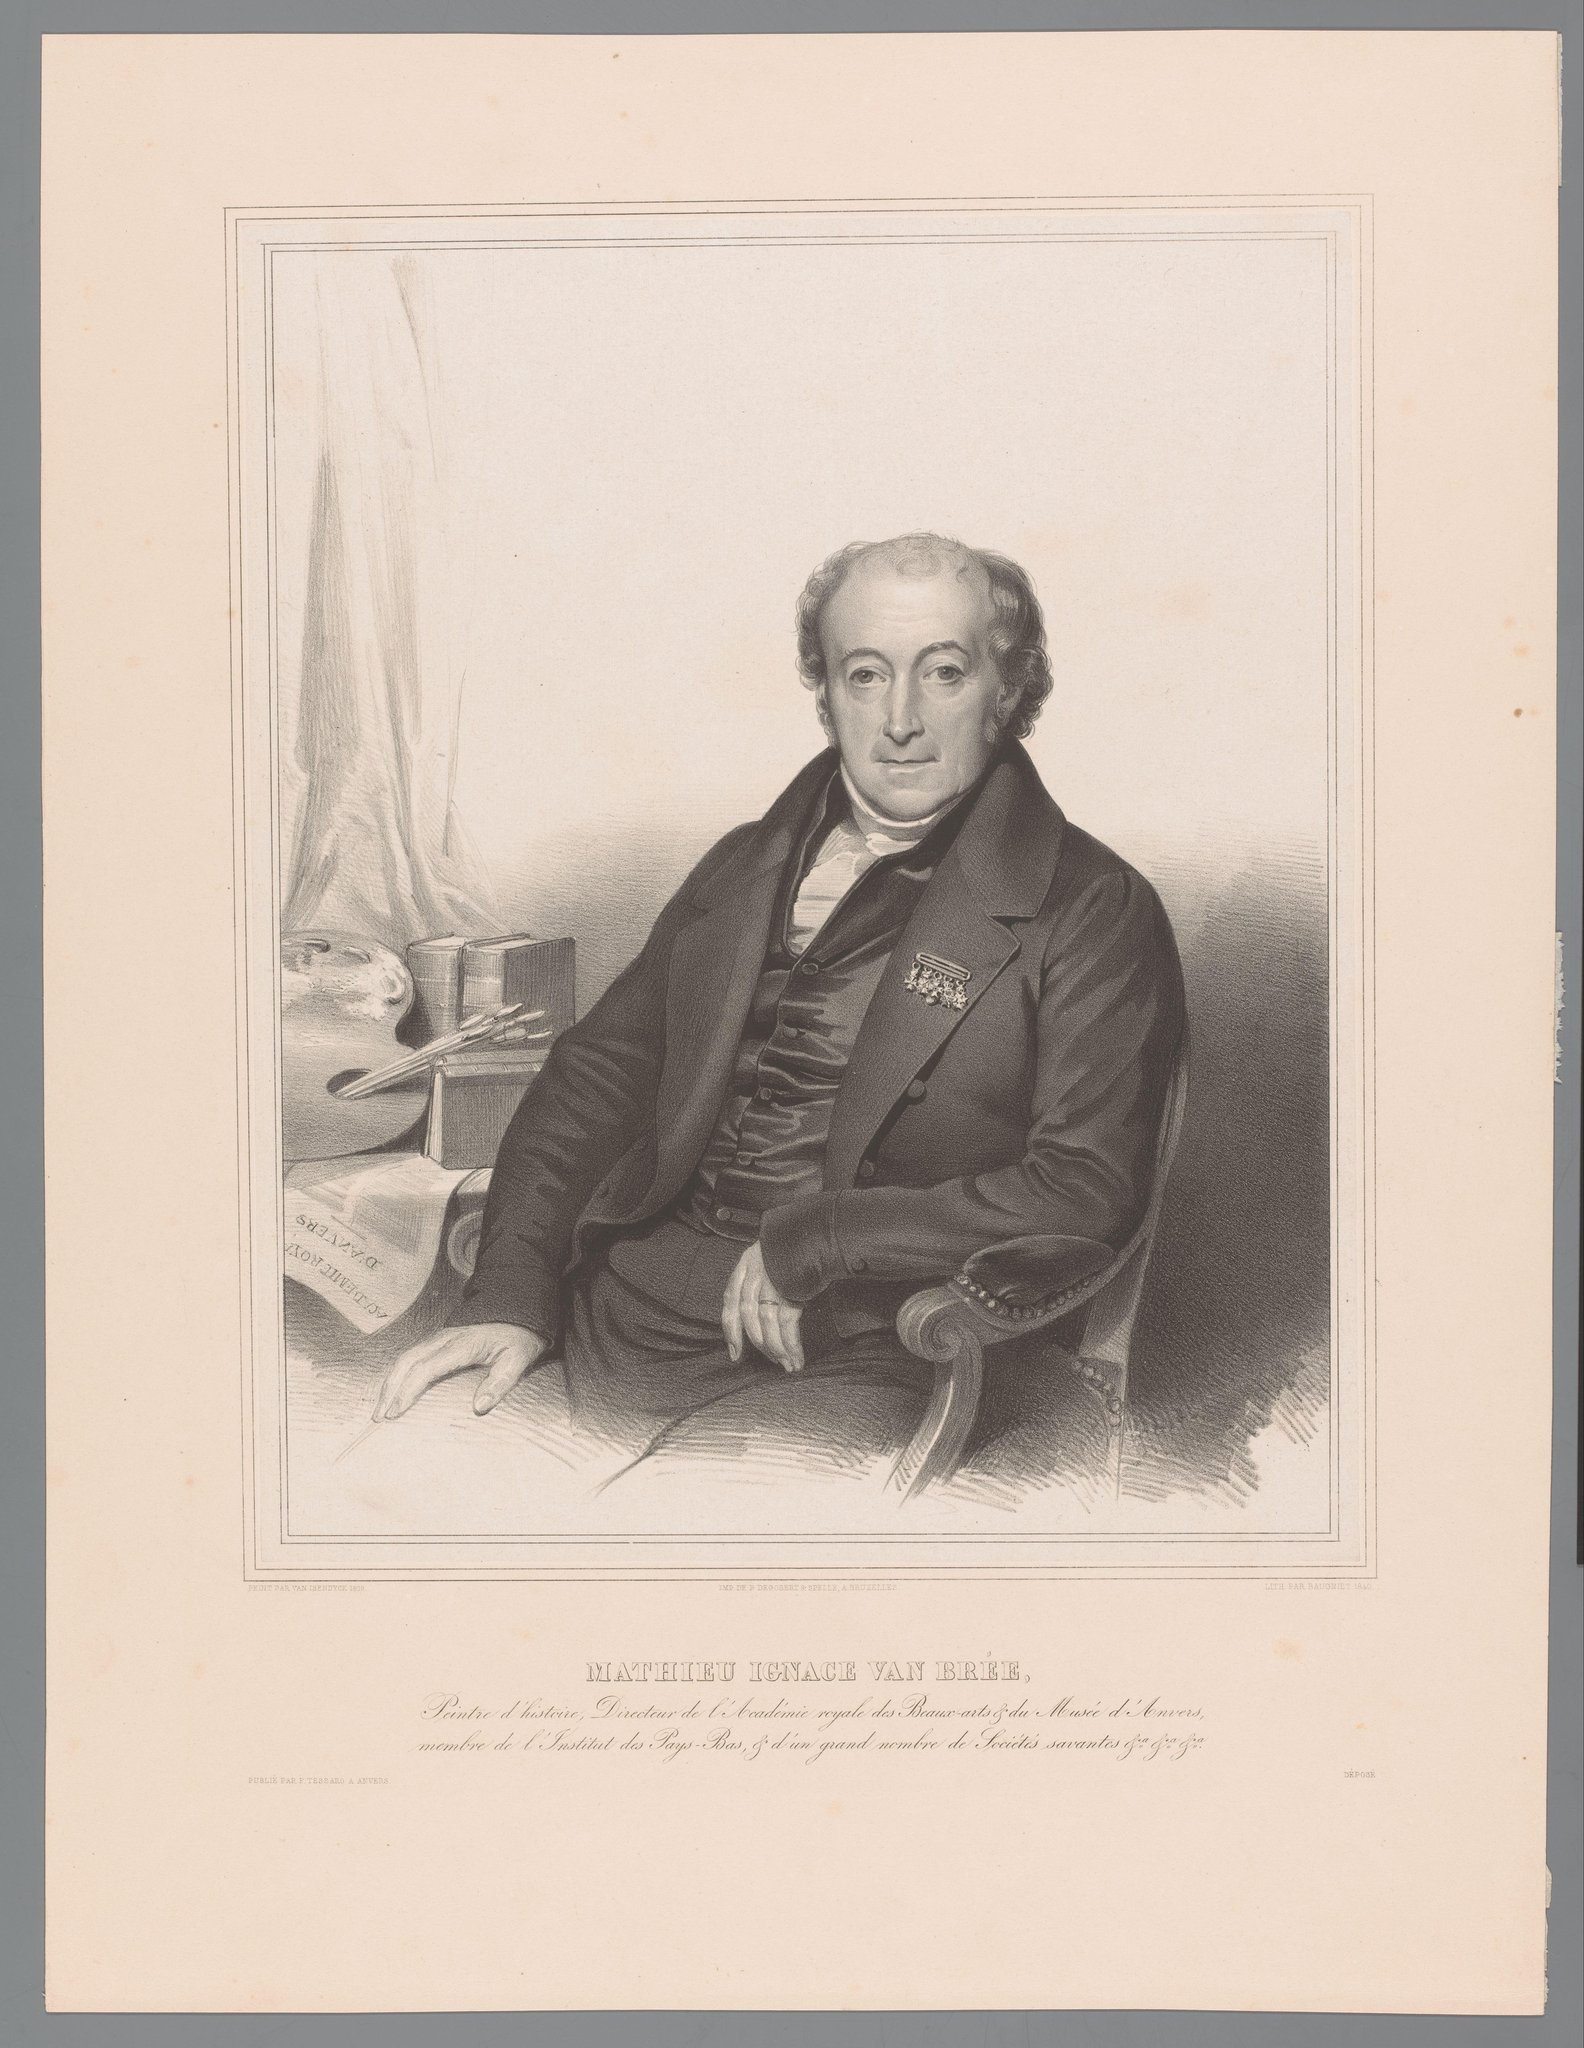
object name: print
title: Portret van Mattheus Ignatius van Bree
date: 1840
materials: paper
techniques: lithograph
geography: brussels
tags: antwerp, print maker, draughtsman, mattheus ignatius van bree, adult man, historical persons, book, palette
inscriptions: : ‘dépose’, collector's mark: Lugt 2228